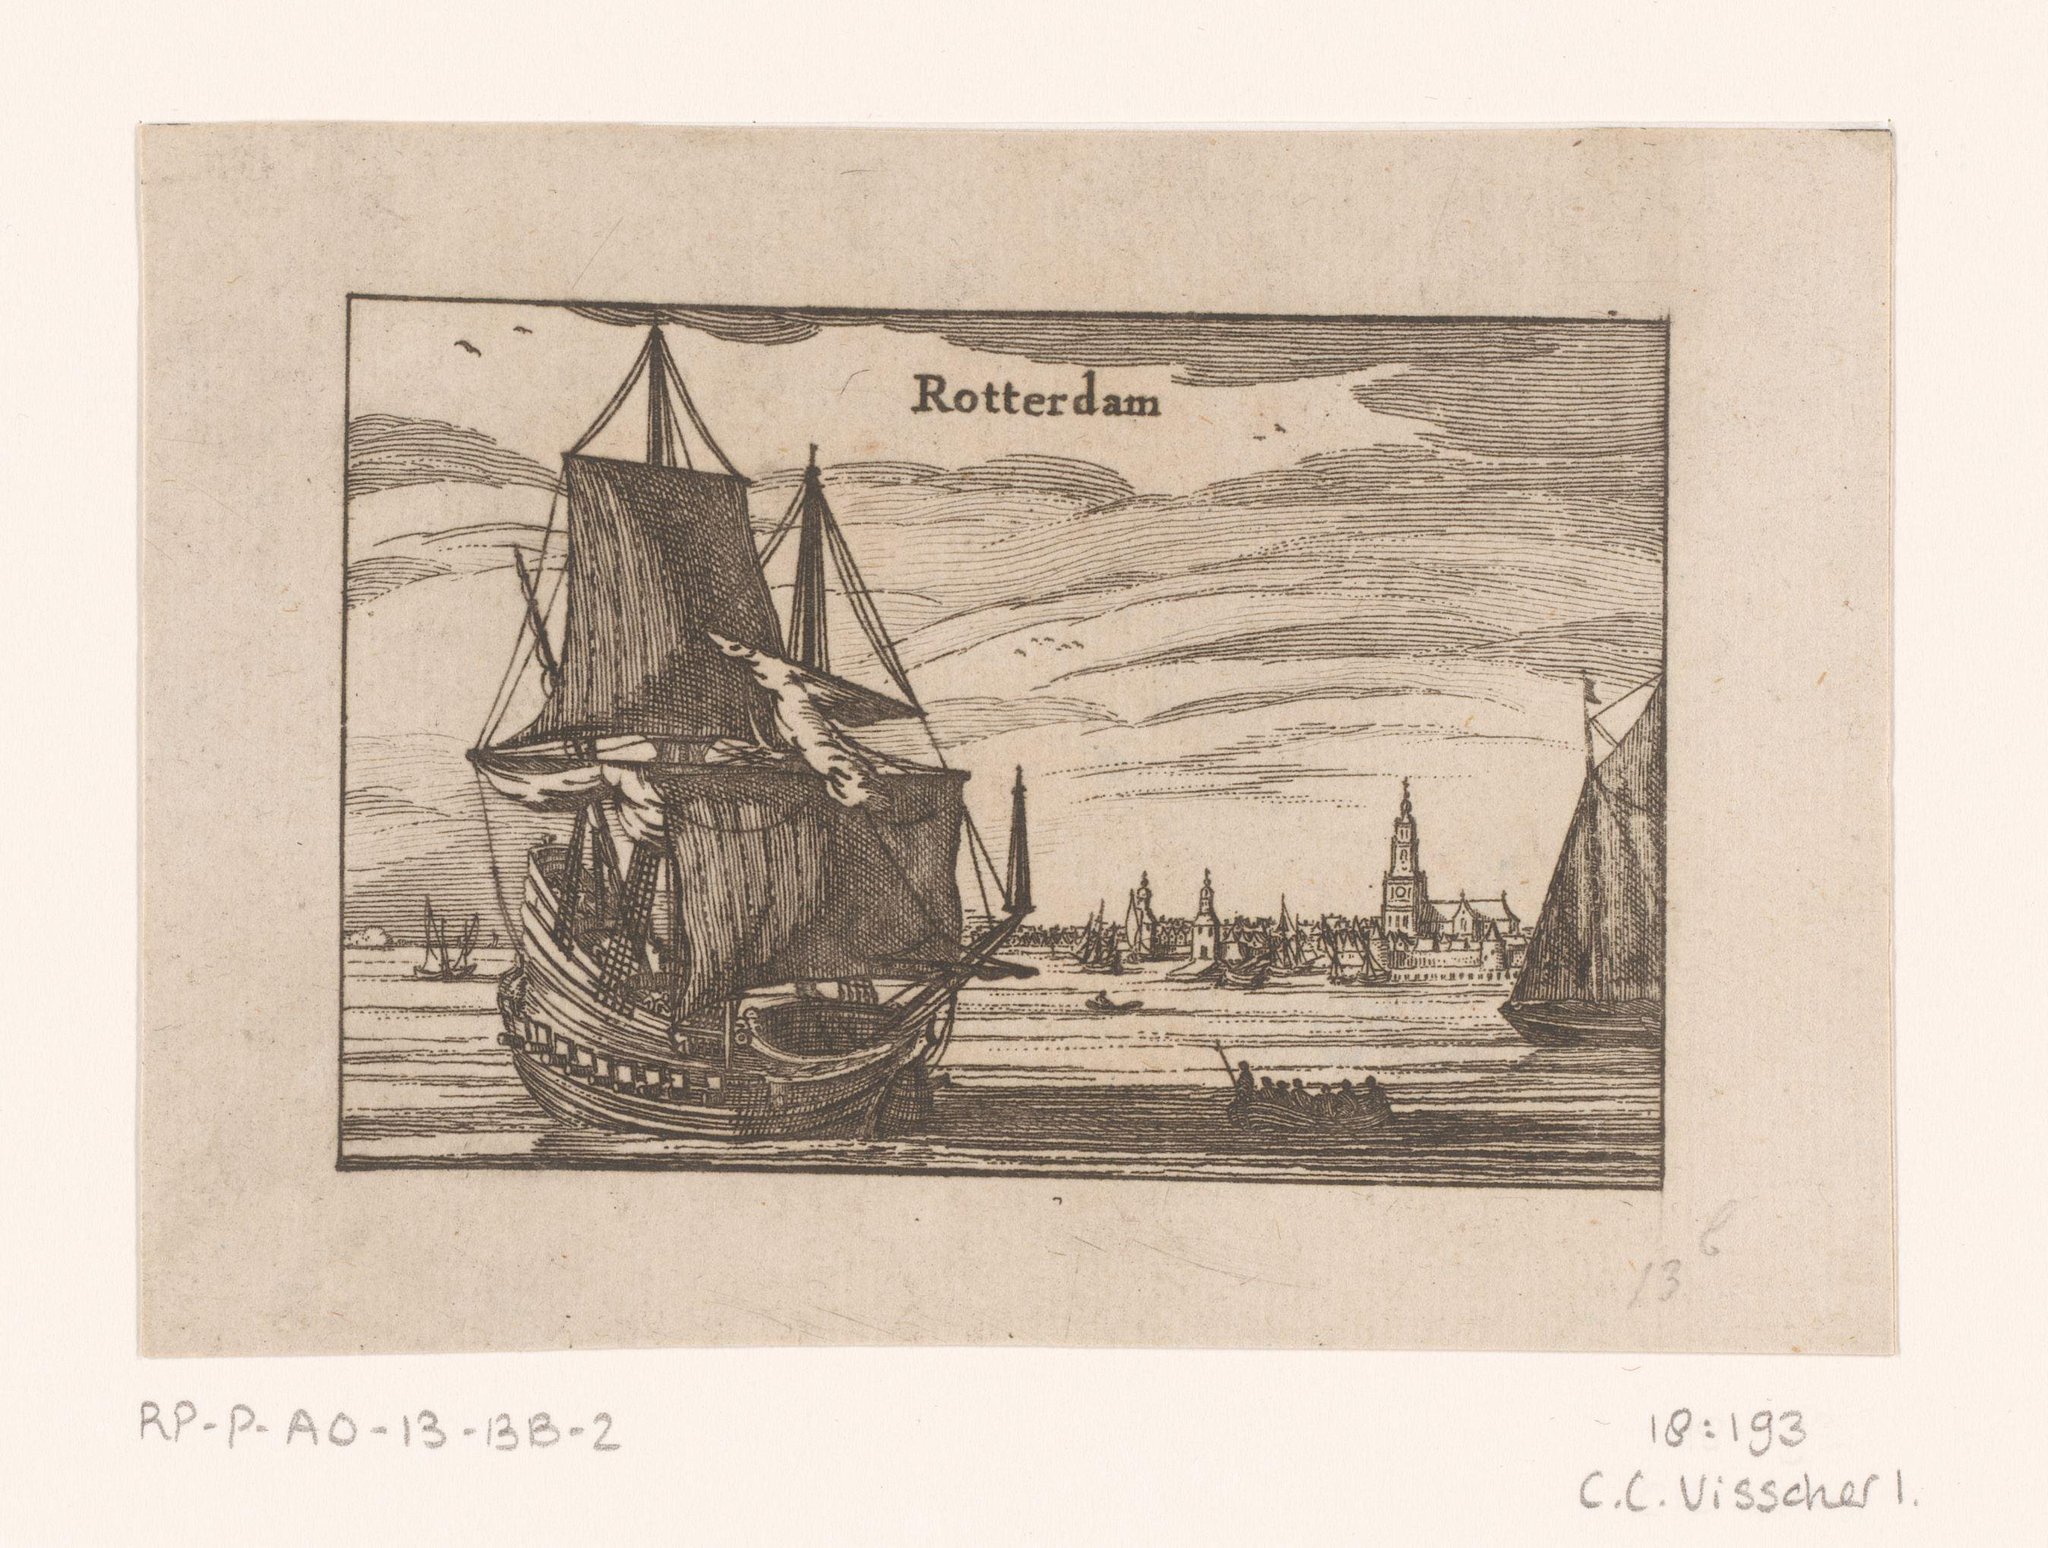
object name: print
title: Gezicht op Rotterdam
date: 1652-1679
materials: paper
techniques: etching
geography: amsterdam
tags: sailing-ship, sailing-boat, church (exterior), prospect of city, town panorama, silhouette of city, rotterdam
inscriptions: collector's mark: Lugt 2228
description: Gezicht op Leiden, gezien vanaf de Maas. Op de voorgrond een zeilschip. Rechts op de achtergrond de stad. Oorspronkelijk onderdeel van een blad met acht gezichten op steden gezien vanaf het water.